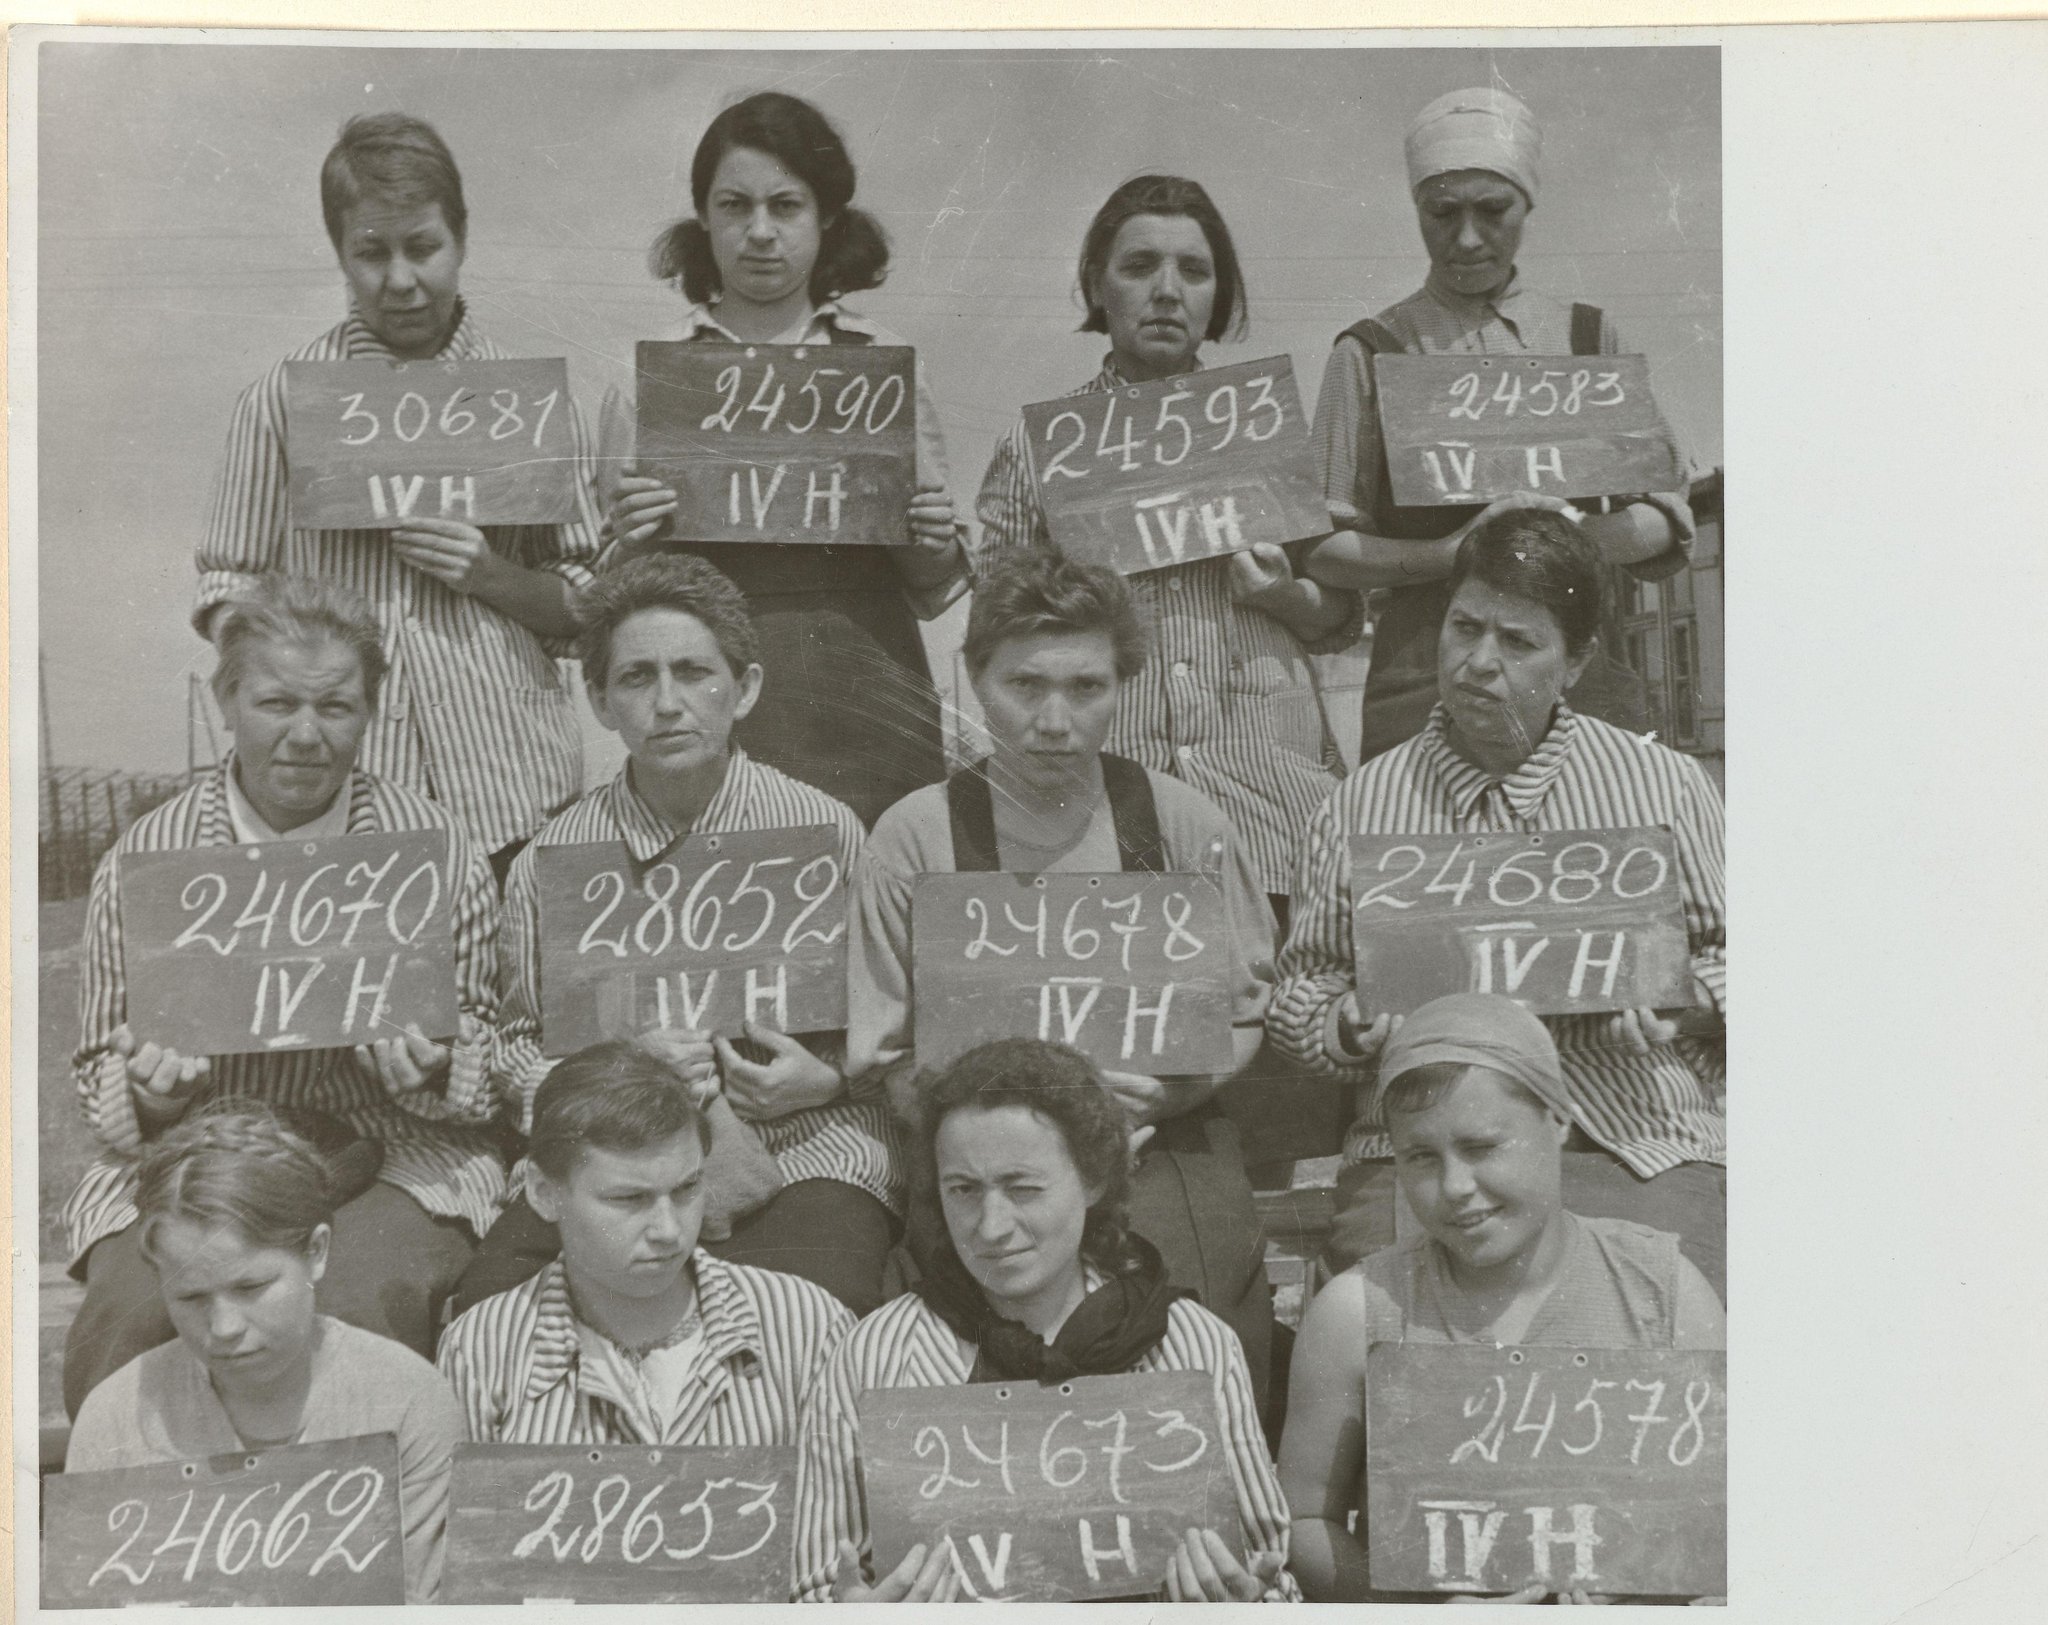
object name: photograph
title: Vrouwelijke gevangenen in het kamp Mühlberg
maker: dick w.b. van maarseveen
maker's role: fotograaf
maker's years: 1905-1990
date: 1943-1945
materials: photographic support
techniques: gelatin silver print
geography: muhlberg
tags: dick w.b. van maarseveen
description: Een groep van twaalf vrouwelijke gevangenen in het kamp Mühlberg. Poserend in gestreepte kampjassen en met een bord met registratienummer in de handen. Waarschijnlijk de vrouwelijke verdedigers van Warschau tijdens de grote opstand eind 1944. Onderdeel van een groep foto's gemaakt door Dick van Maarseveen in het Duitse krijgsgevangenenkamp Stalag IV B in Mühlberg in de periode 1943-1945.